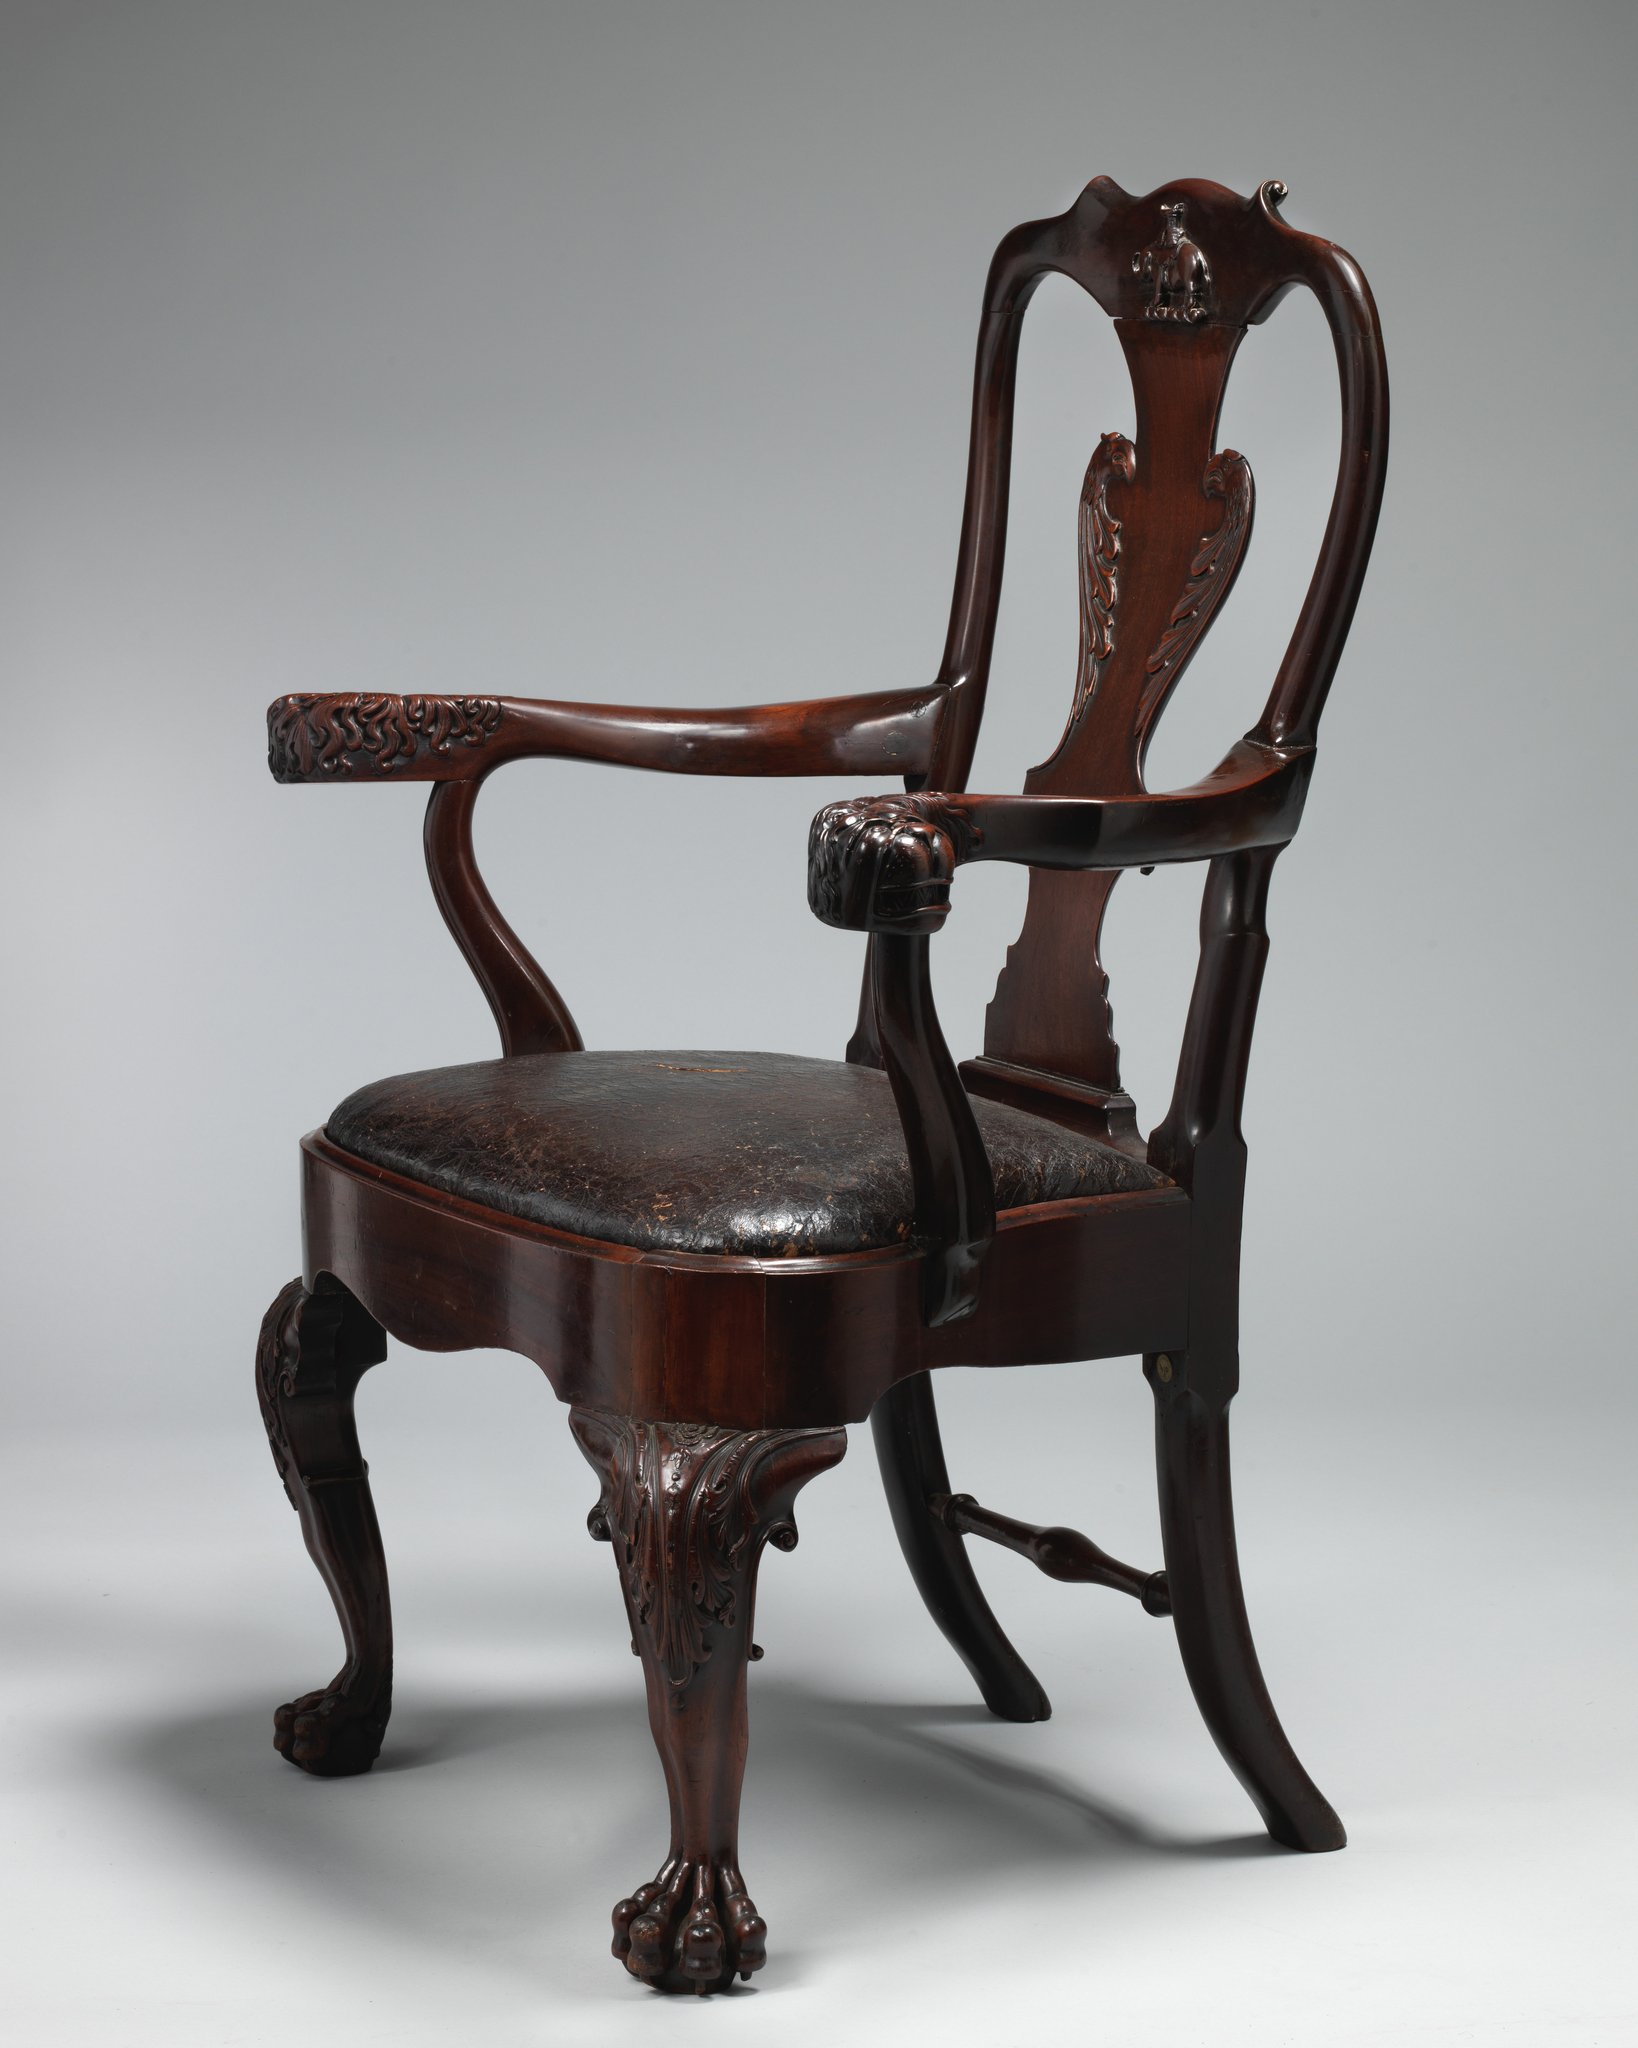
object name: armchair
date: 1730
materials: wood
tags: elephants